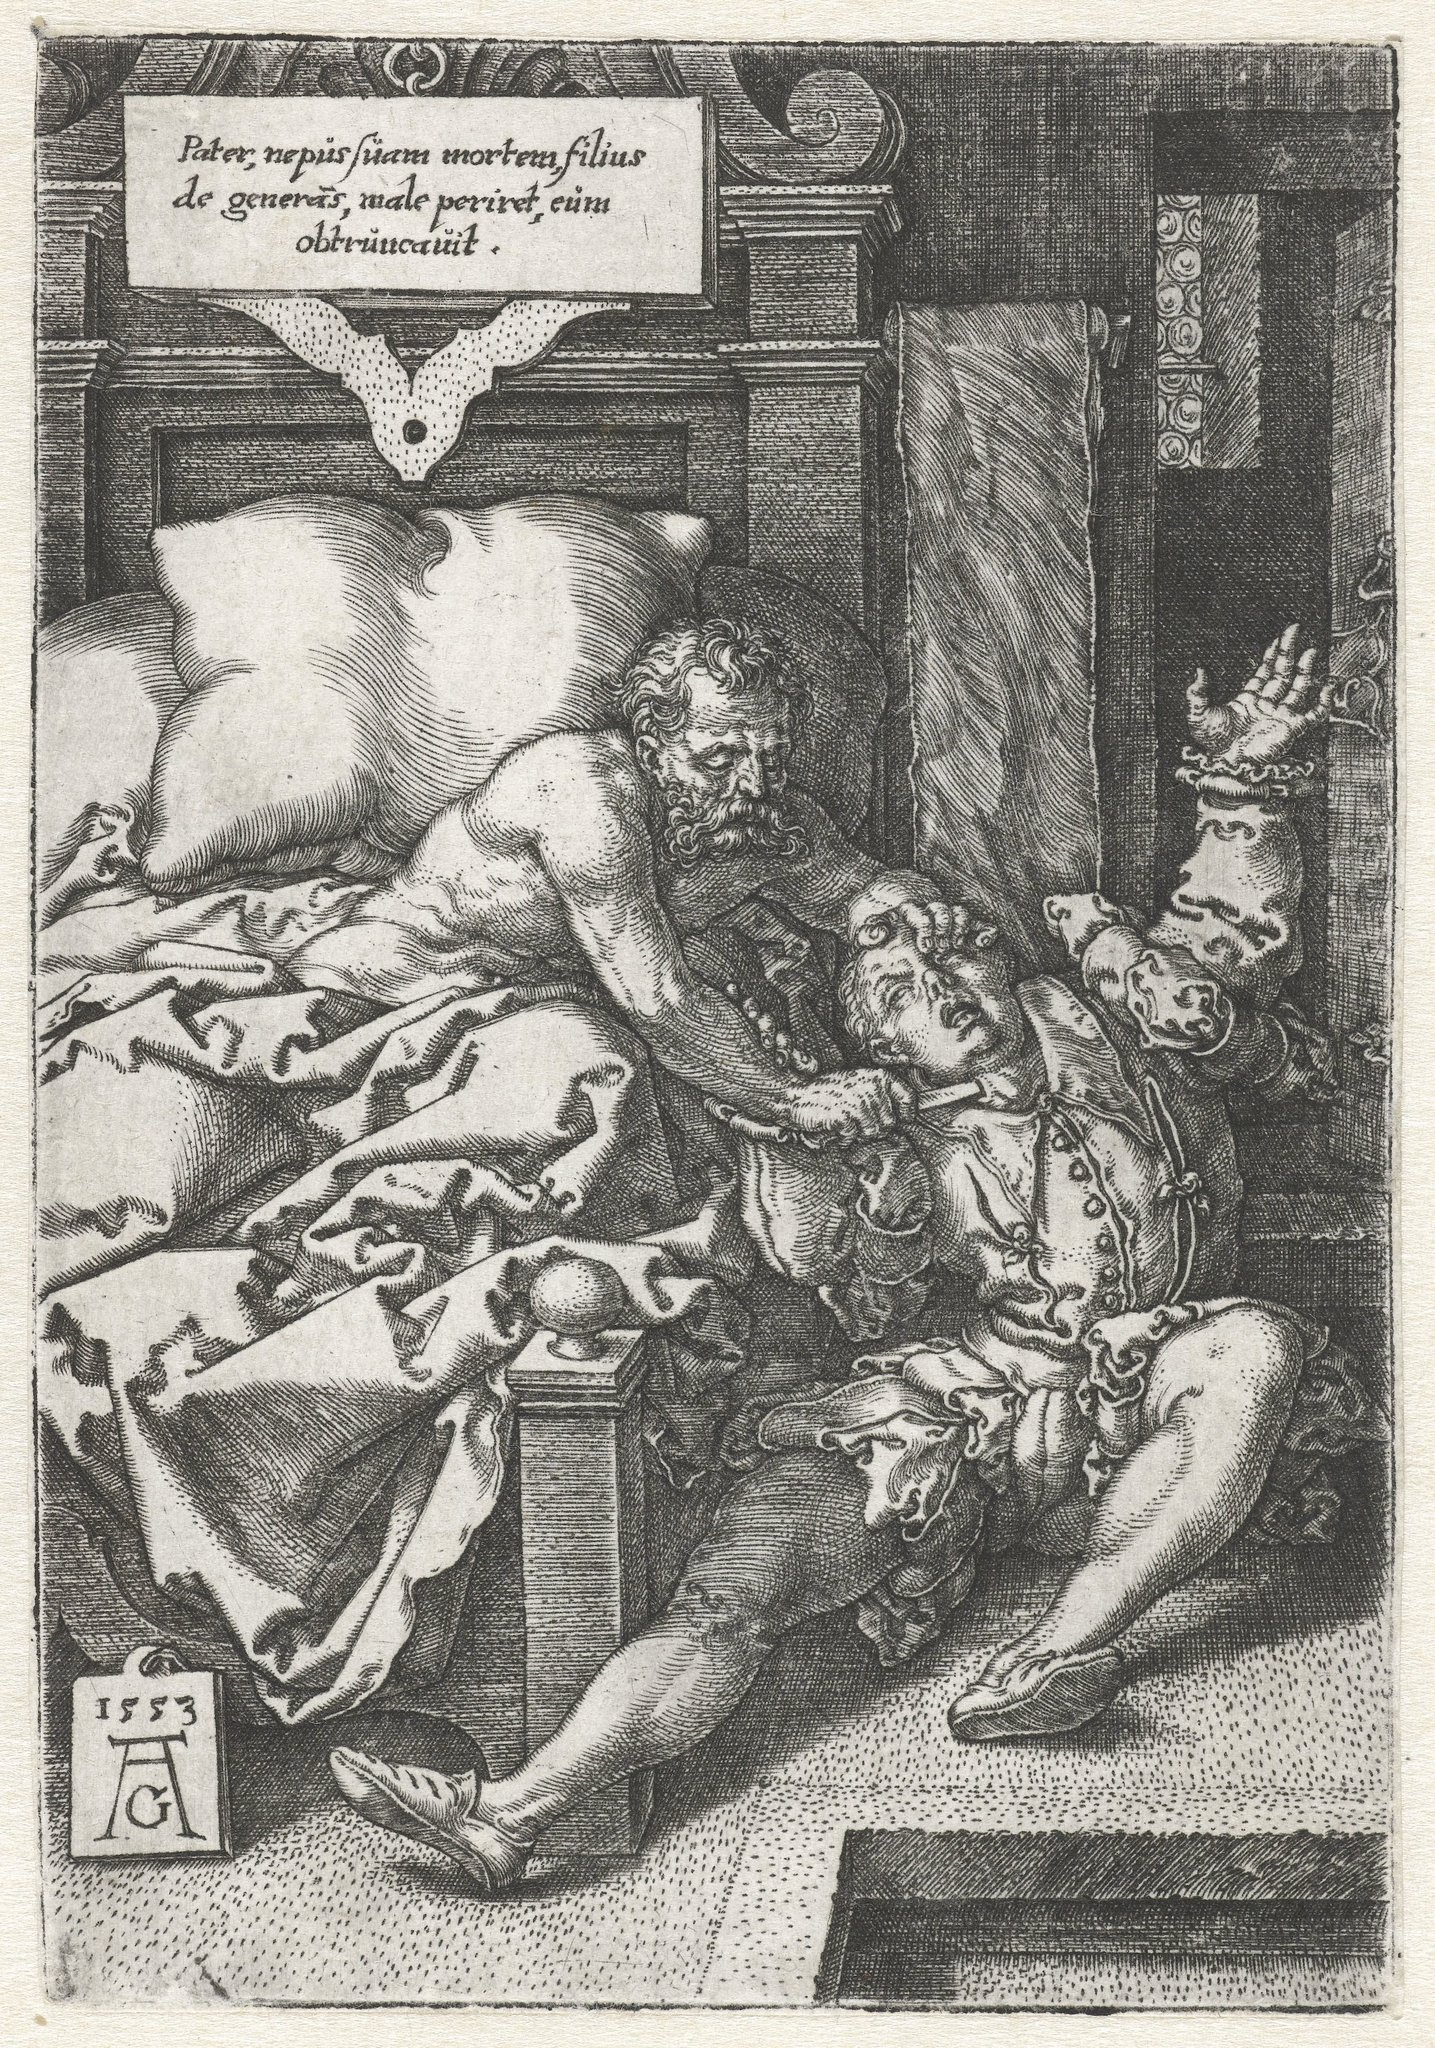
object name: print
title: Vader doodt zijn zoon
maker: heinrich aldegrever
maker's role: draughtsman, print maker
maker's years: 1502-1561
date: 1553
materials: paper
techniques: engraving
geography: germany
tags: the (nude) human figure; 'corpo humano' (ripa) (+ killing)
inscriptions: date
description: Herkinbald (Archimbald) liggend in bed, steekt zijn neef in de hals met een mes. Hij was een van de voorvaders van de graven van Bourbon. Boven het bed een cartouche met een drieregelige tekst in het Latijn.